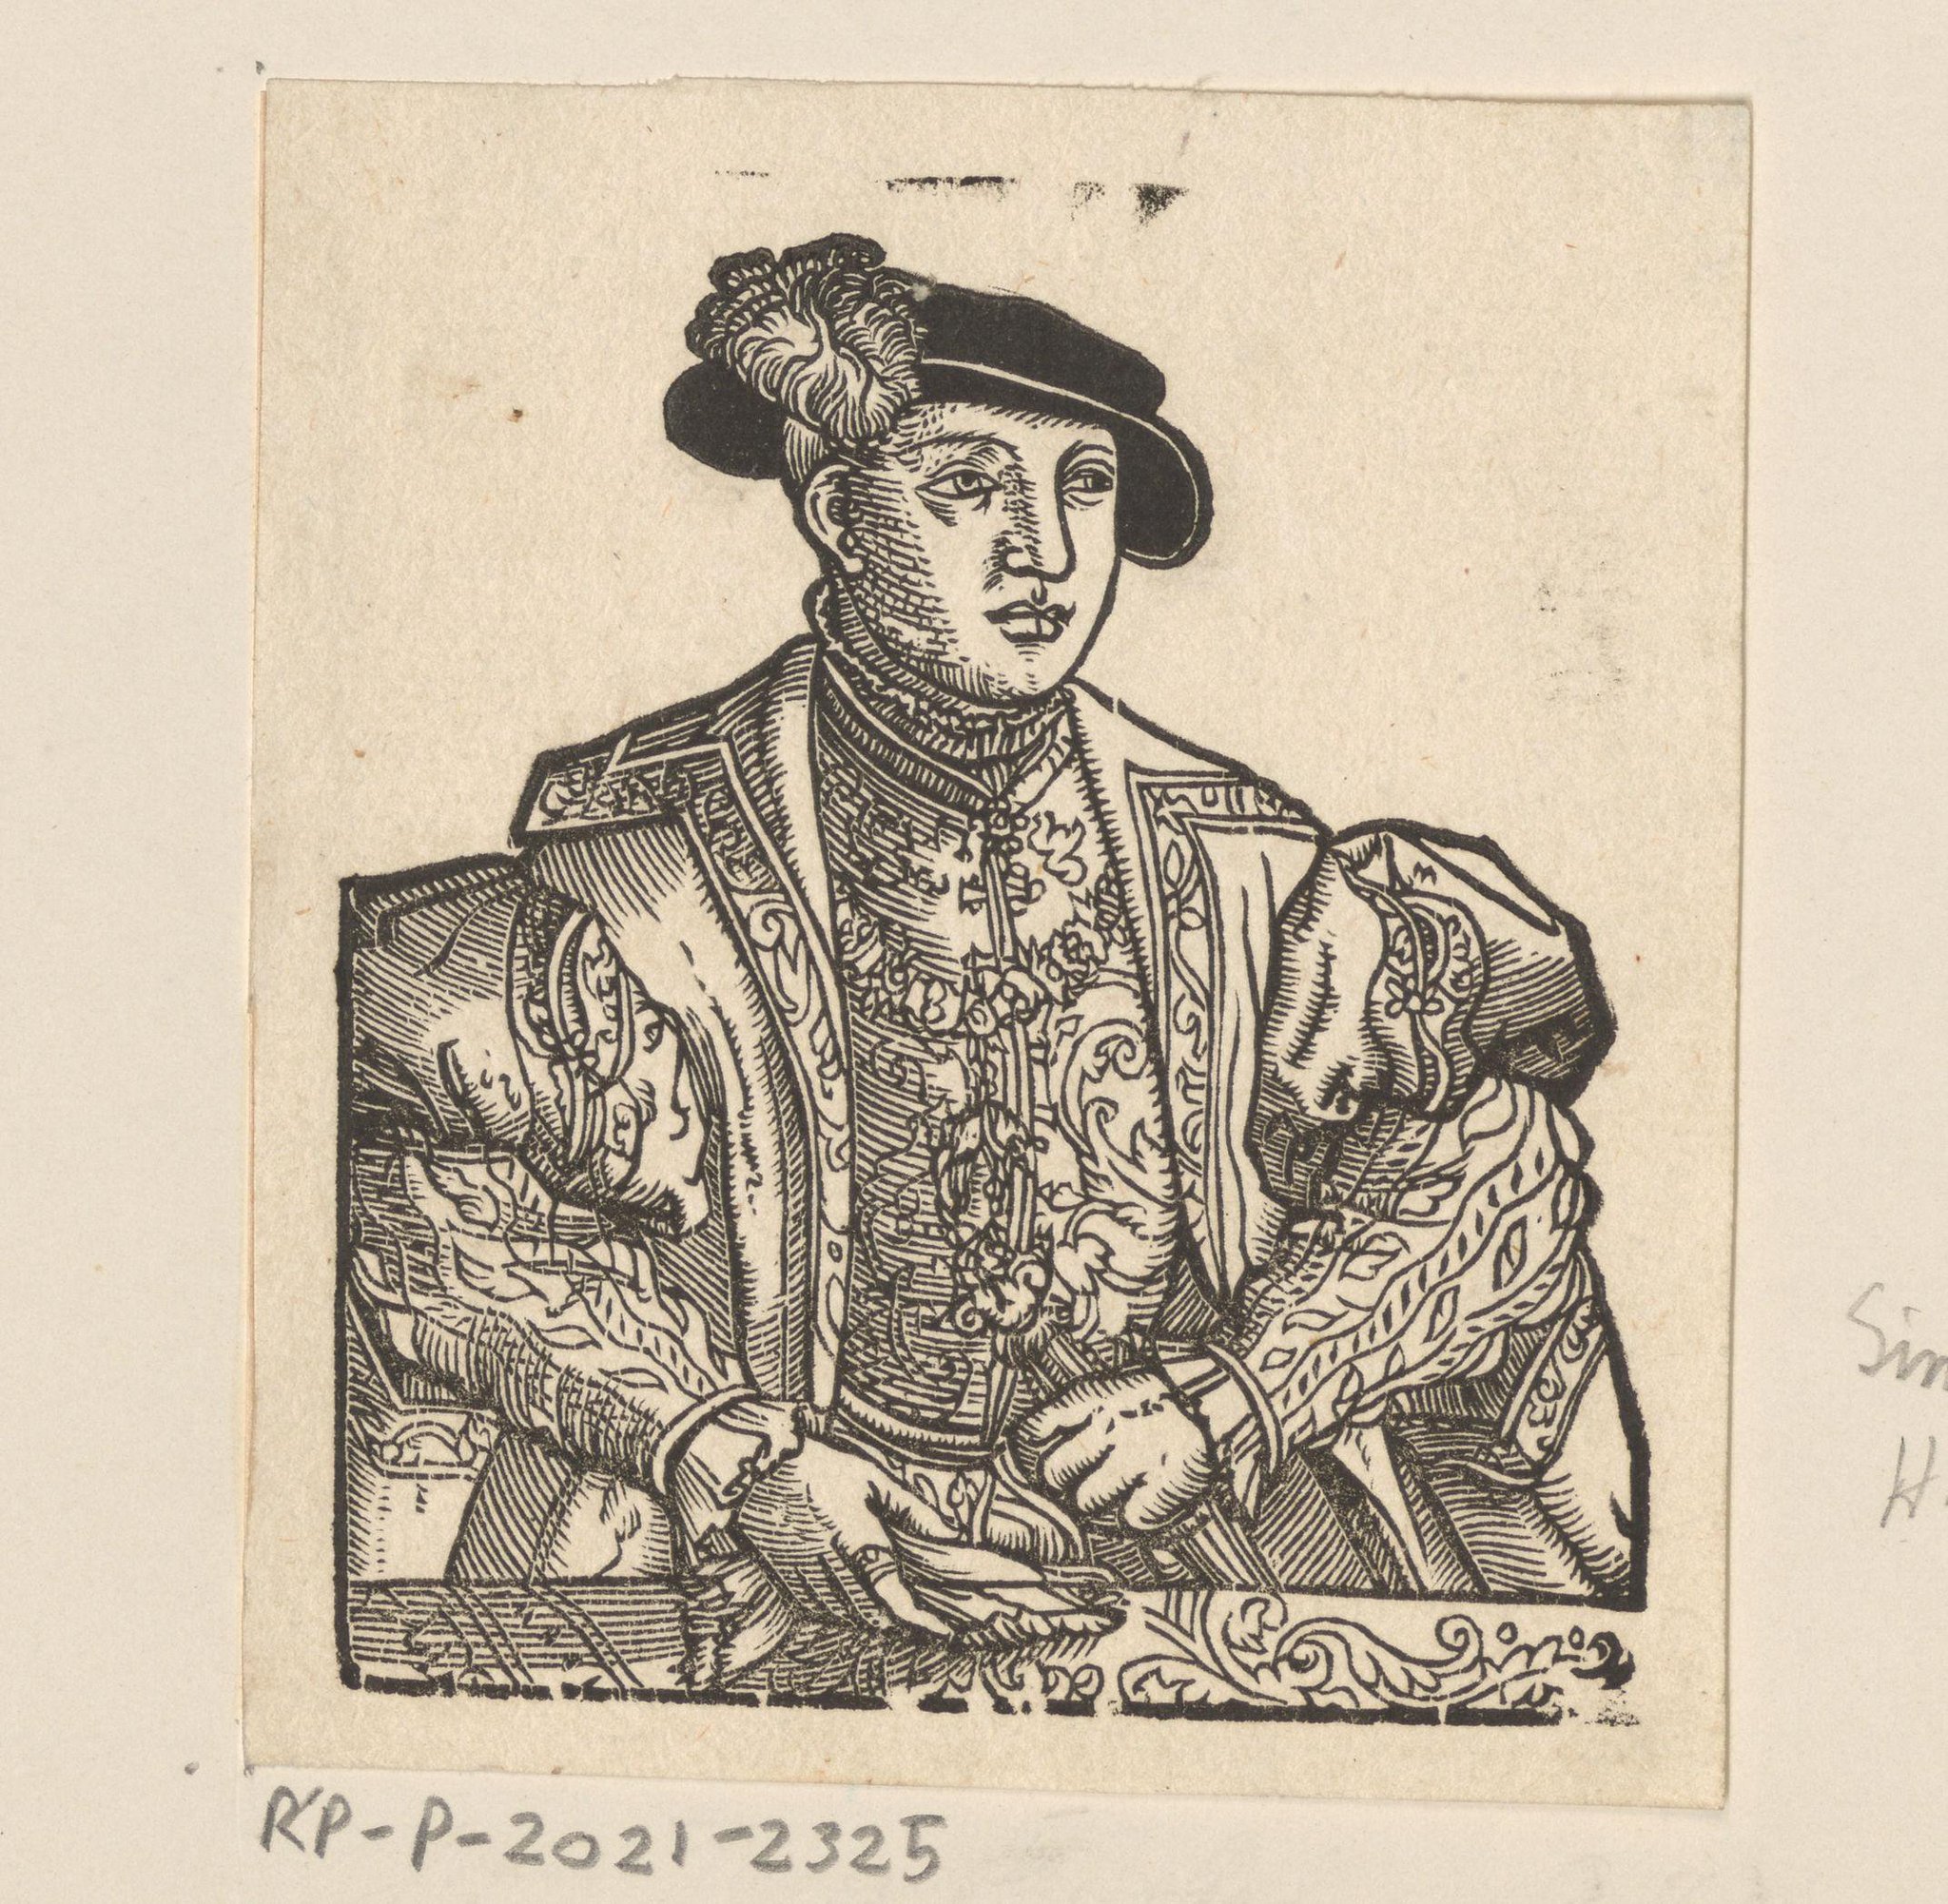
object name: print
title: Portret van Johan Frederik II, hertog van Saksen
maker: Anonymous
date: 1600-1699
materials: paper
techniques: woodcut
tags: head-gear, historical persons, ruler, sovereign